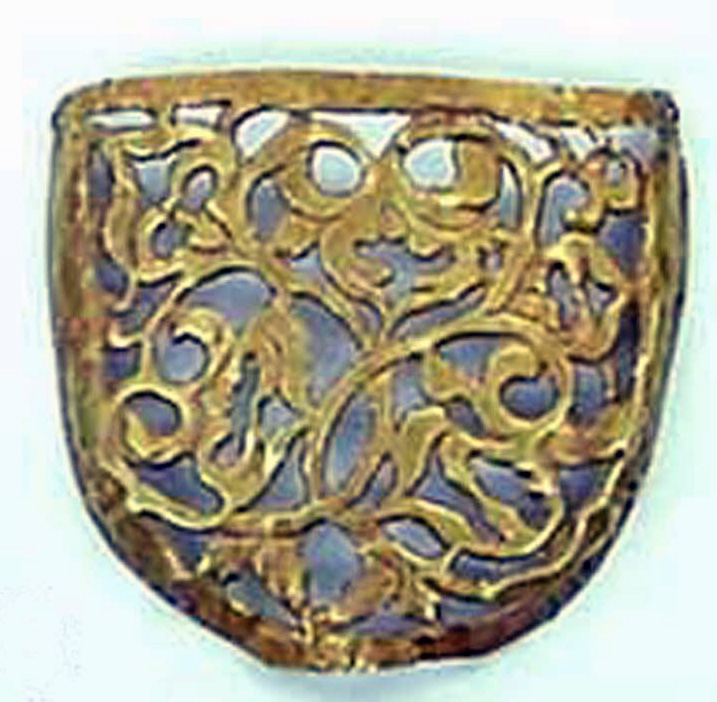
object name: fitting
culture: northwest chinese or eastern central asian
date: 634-900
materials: gold